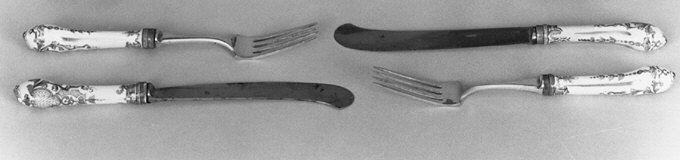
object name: knife and fork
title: Twelve pairs of knives and forks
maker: vienna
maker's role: manufactory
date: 1730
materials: hard paste porcelain, steel